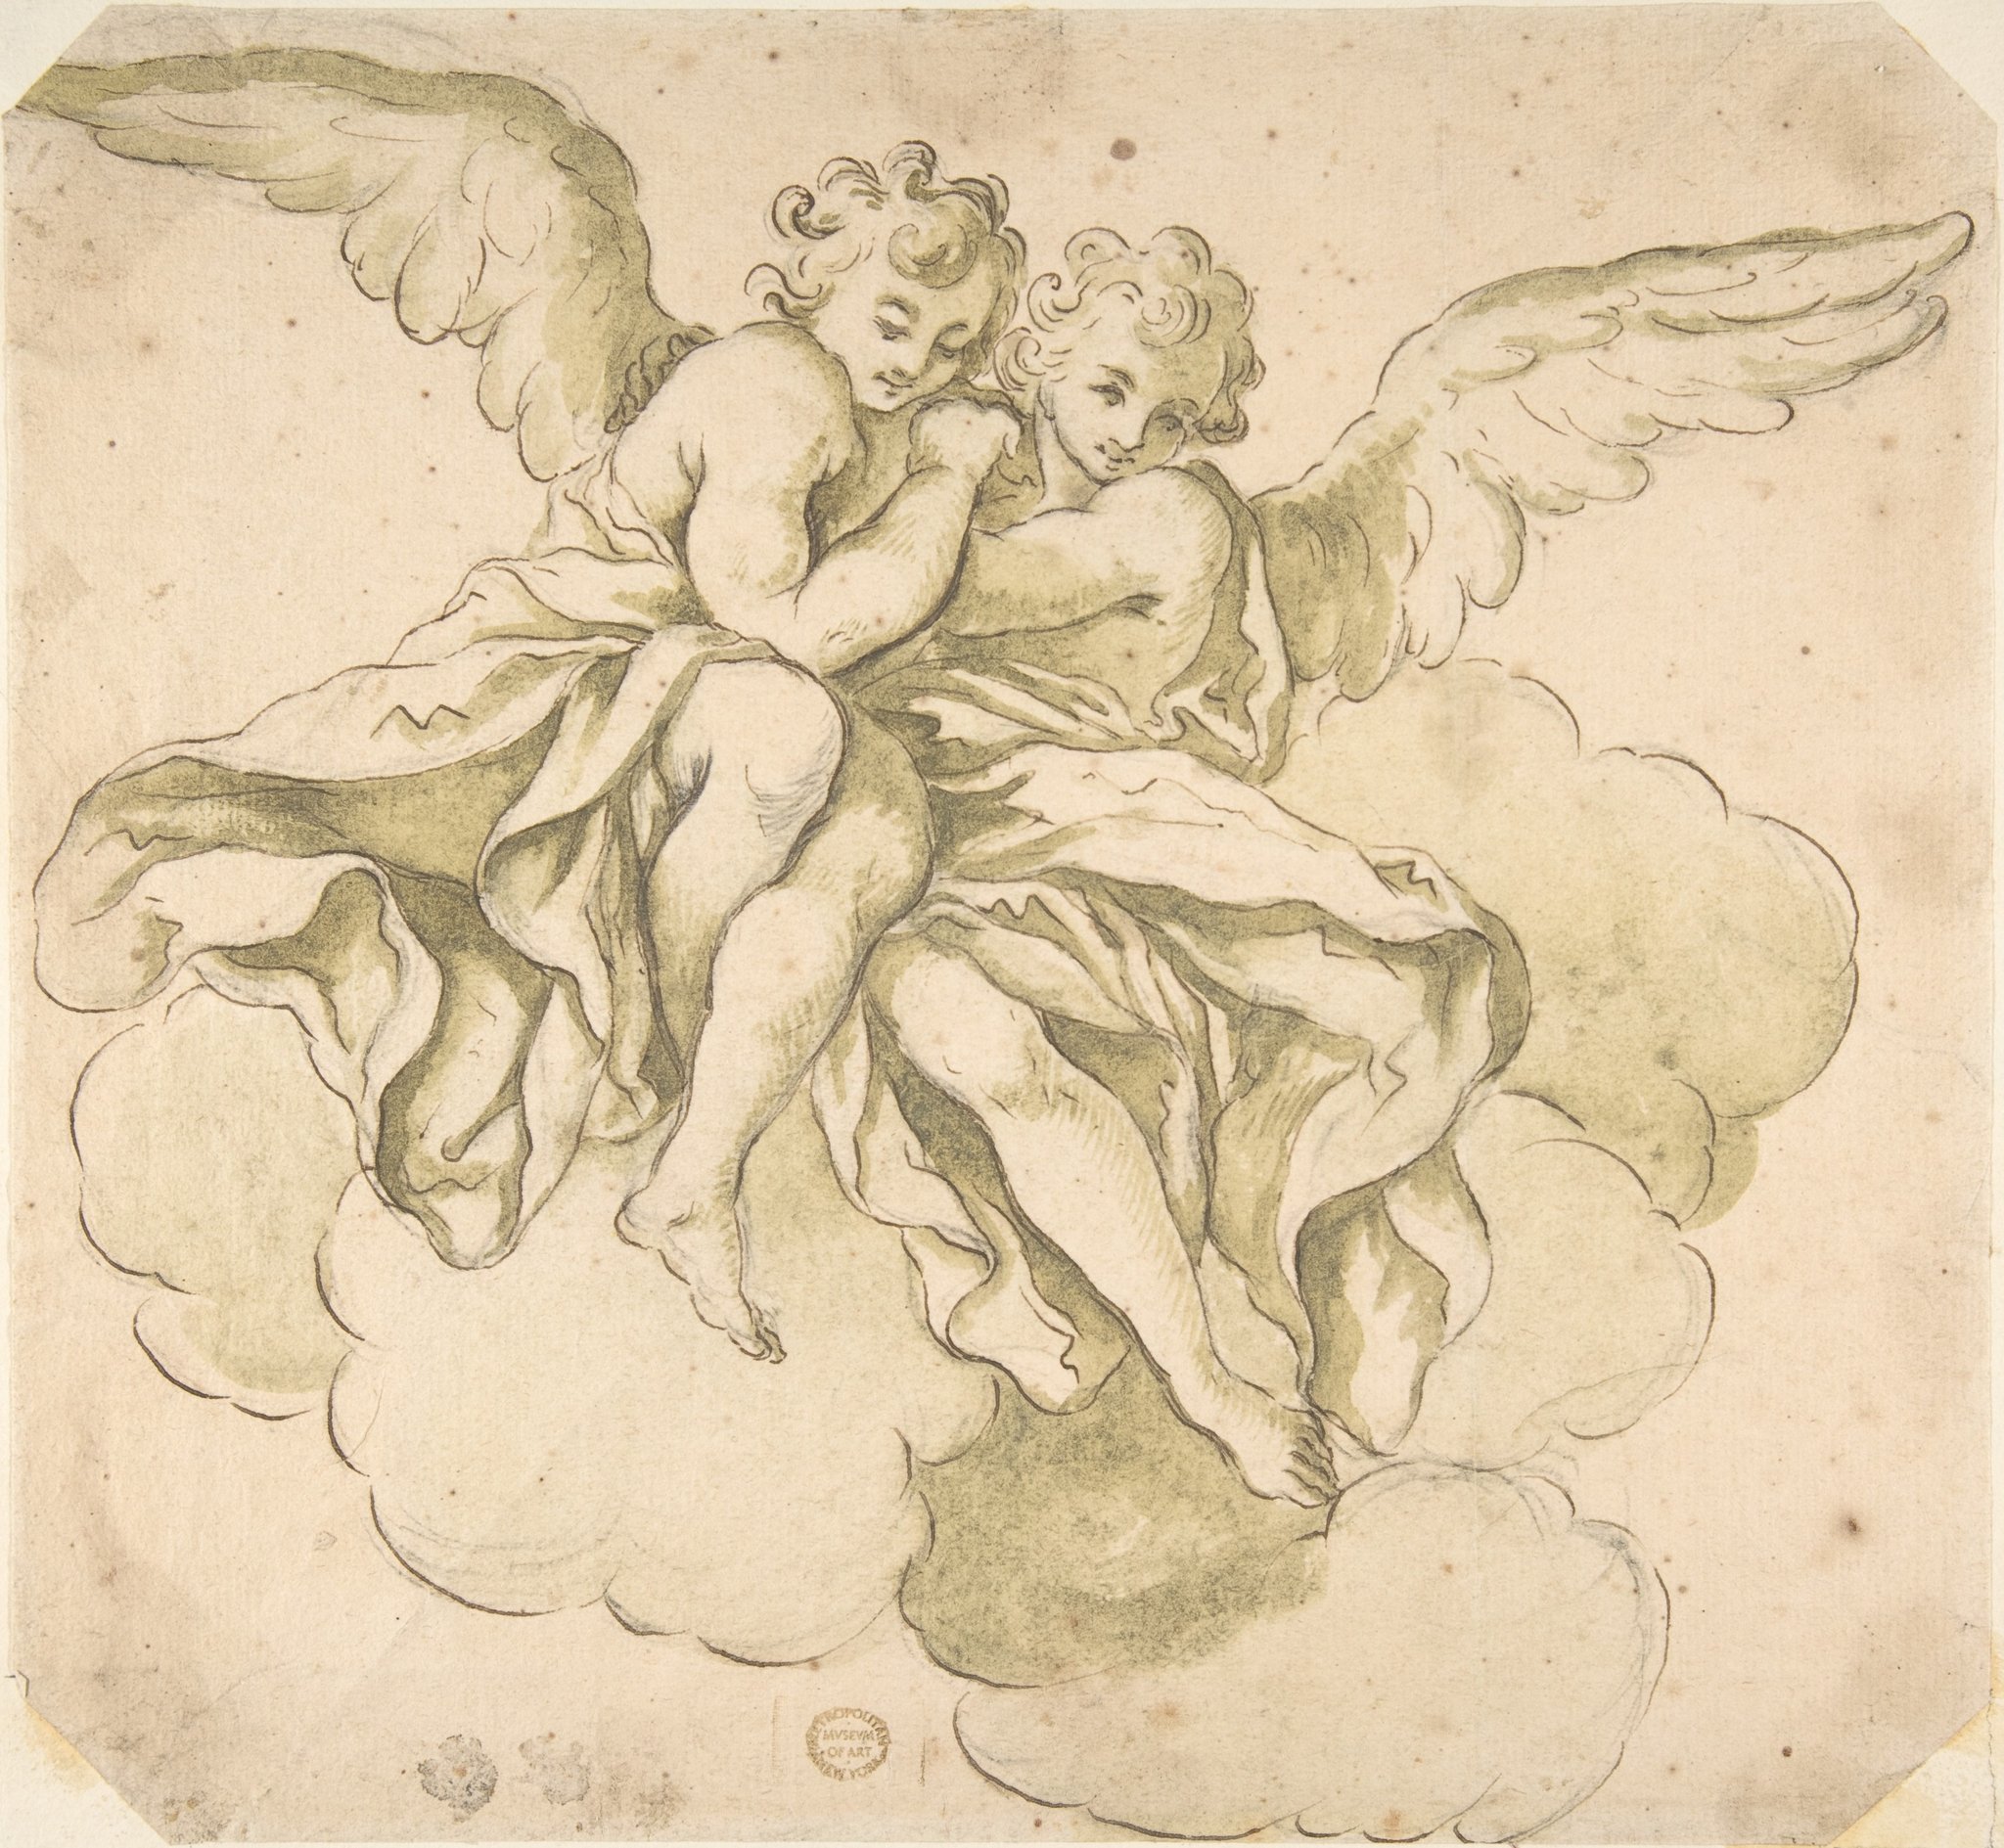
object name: drawing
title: Two Angels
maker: anonymous, italian, roman-bolognese, 17th century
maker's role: artist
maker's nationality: italian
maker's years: 1600-1700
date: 1601-1700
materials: chalk, ink, paper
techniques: brush, pen, wash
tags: angels